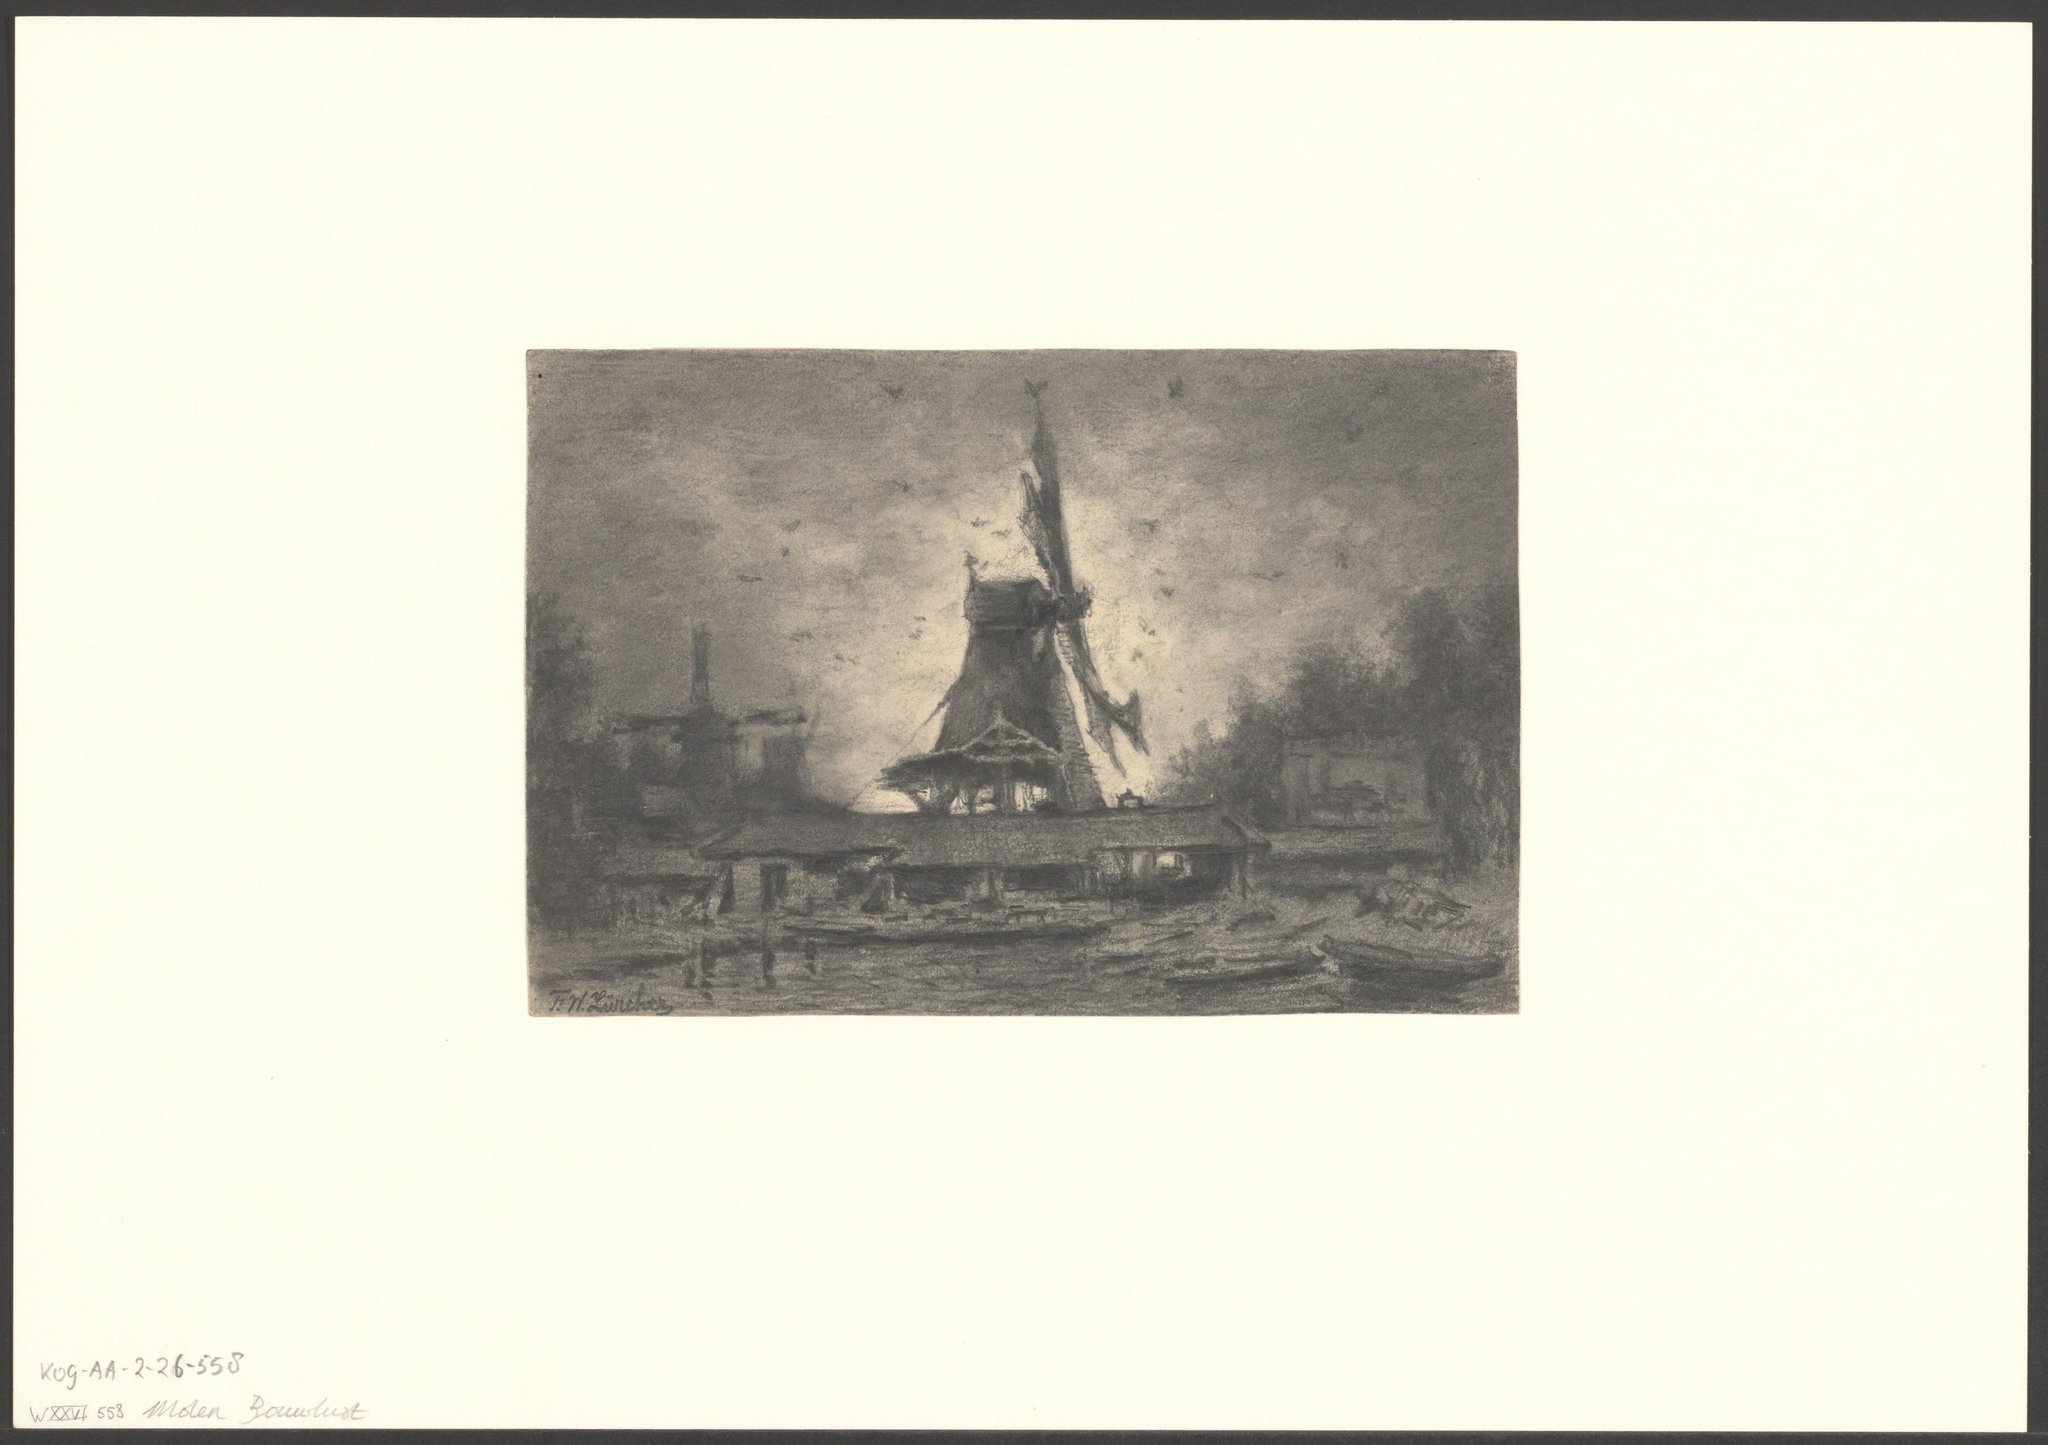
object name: drawing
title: Gezicht op de Zaagmolensloot met molen Bouwlust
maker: frederik willem zürcher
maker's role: draughtsman, print maker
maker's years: 1835-1894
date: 1845-1877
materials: chalk, paper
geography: amsterdam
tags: city-view in general; 'veduta', windmill in landscape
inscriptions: collector's mark: Lugt 800a, signature: ‘F.W.Zürcher’, inscription: ‘I 479. 62’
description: Tekening binnen de Atlas Van Eck ingedeeld op wijknummer 26.